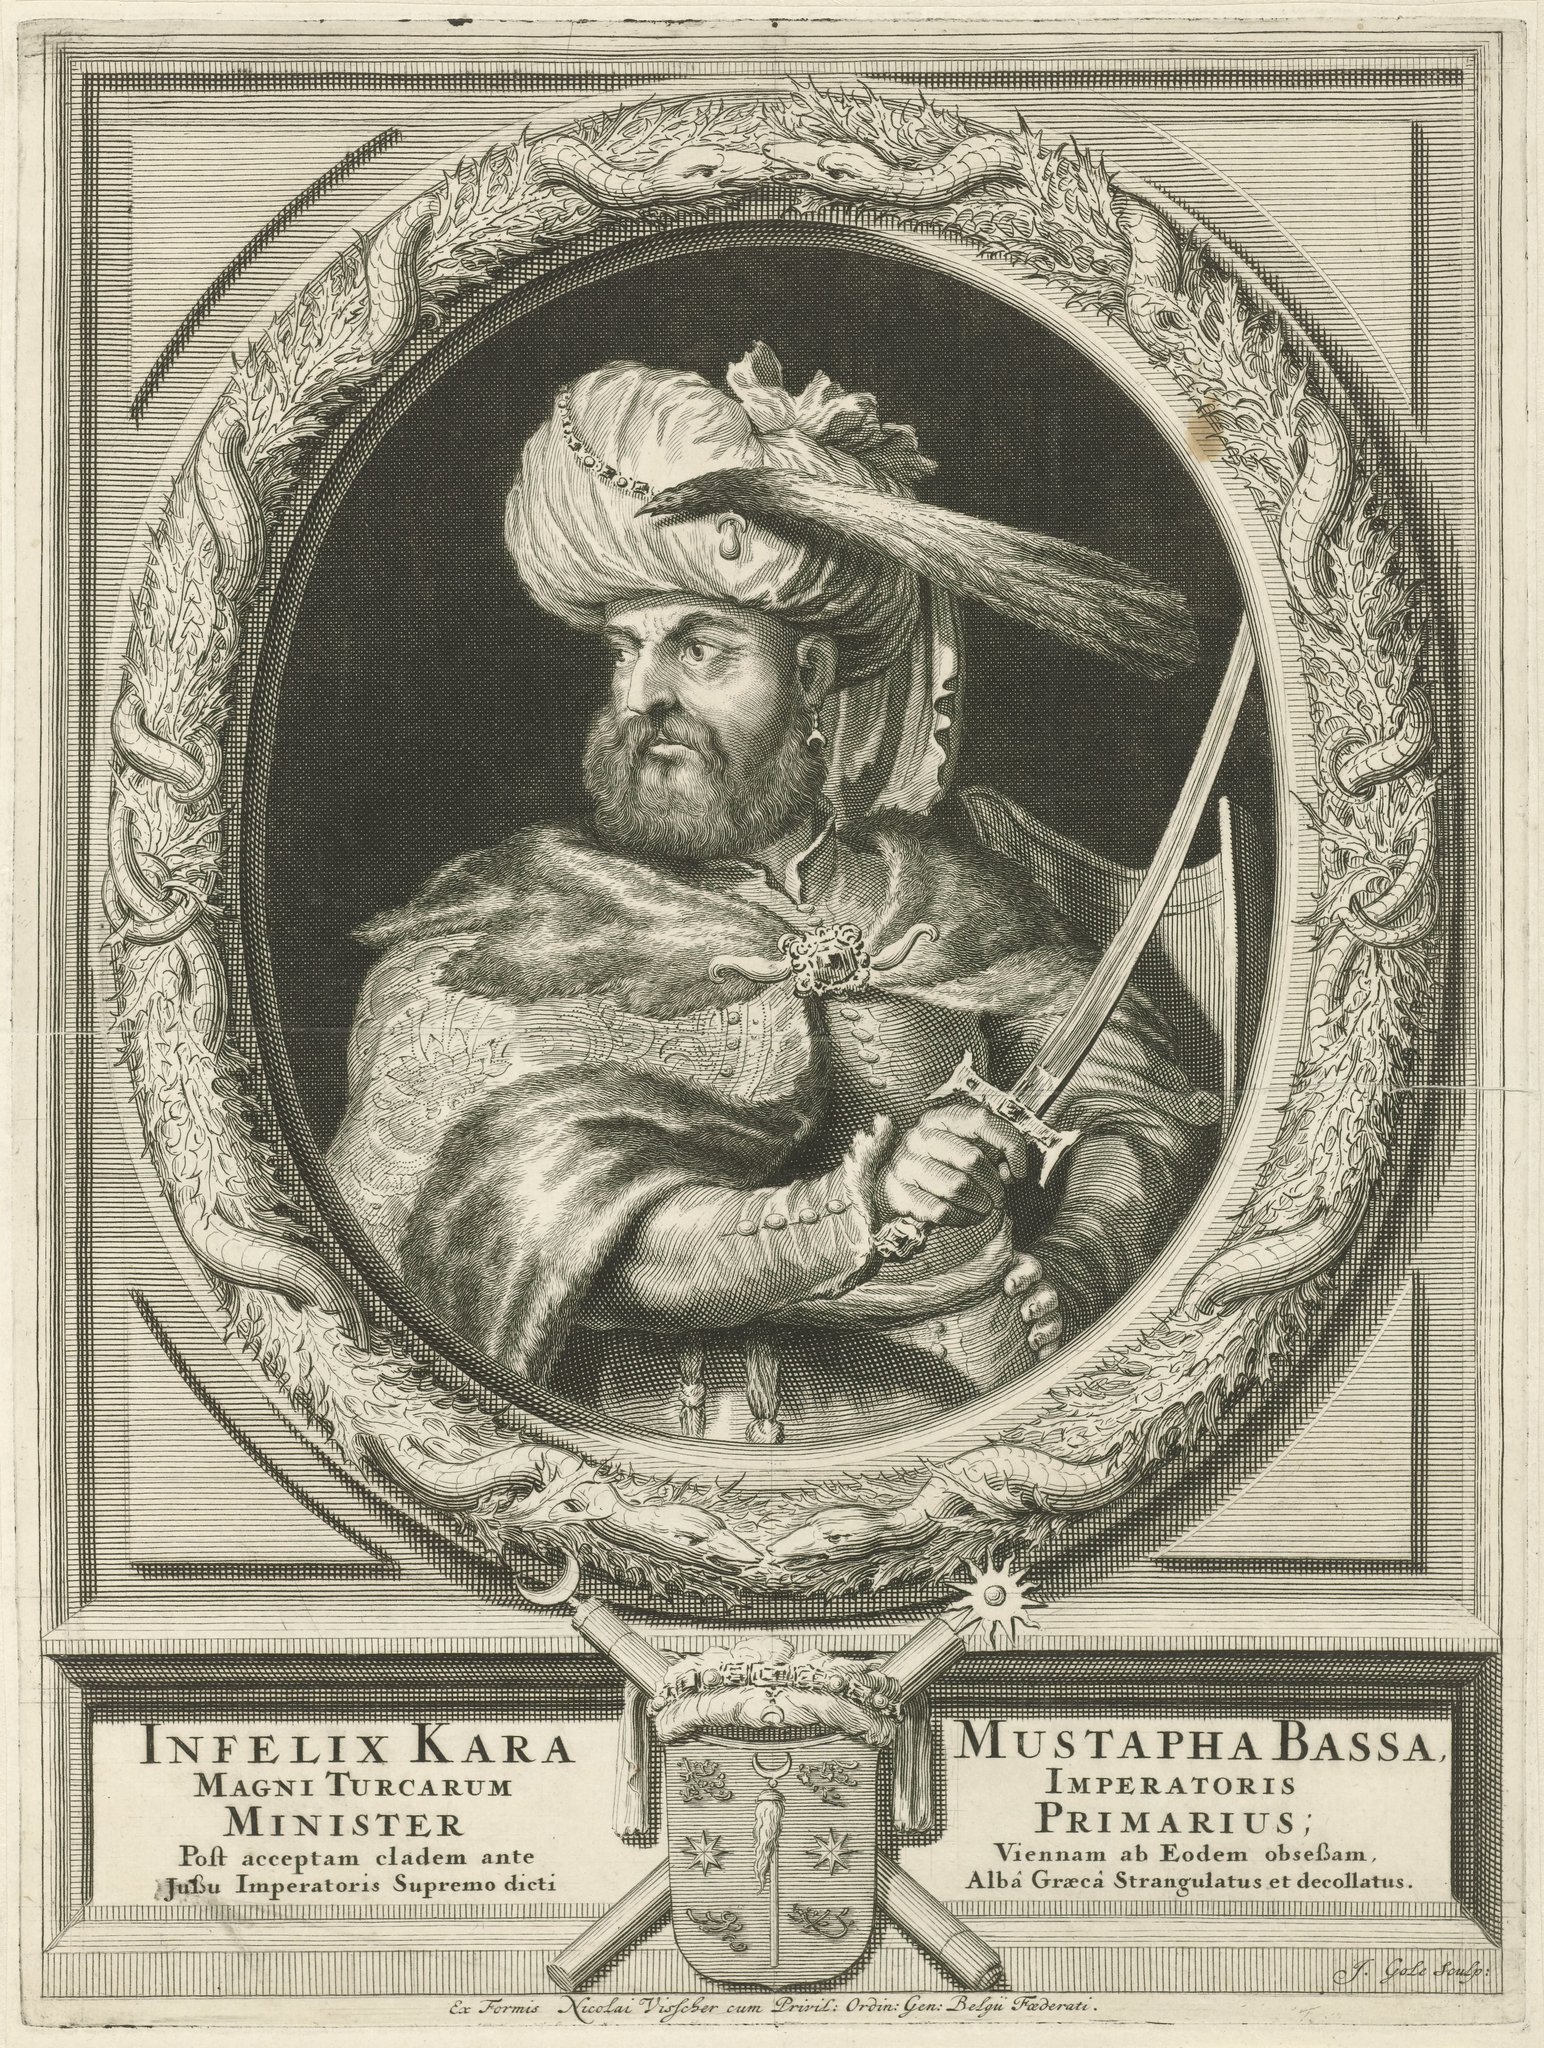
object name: print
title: Portret van Kara Mustafa Pasha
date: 1670-1724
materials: paper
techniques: engraving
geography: amsterdam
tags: belgrado, generaal, kara mustafa pasha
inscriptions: collector's mark: Lugt 2228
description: Portret in ovale lijst van Kara Mustafa Pasha, grootvizier en generaal van het Ottomaanse rijk. Ten halven lijve naar links. Hij heeft een kromzwaard in de hand. Onder het portret het wapenschild van het Ottomaanse rijk. De prent heeft een Latijns onderschrift.